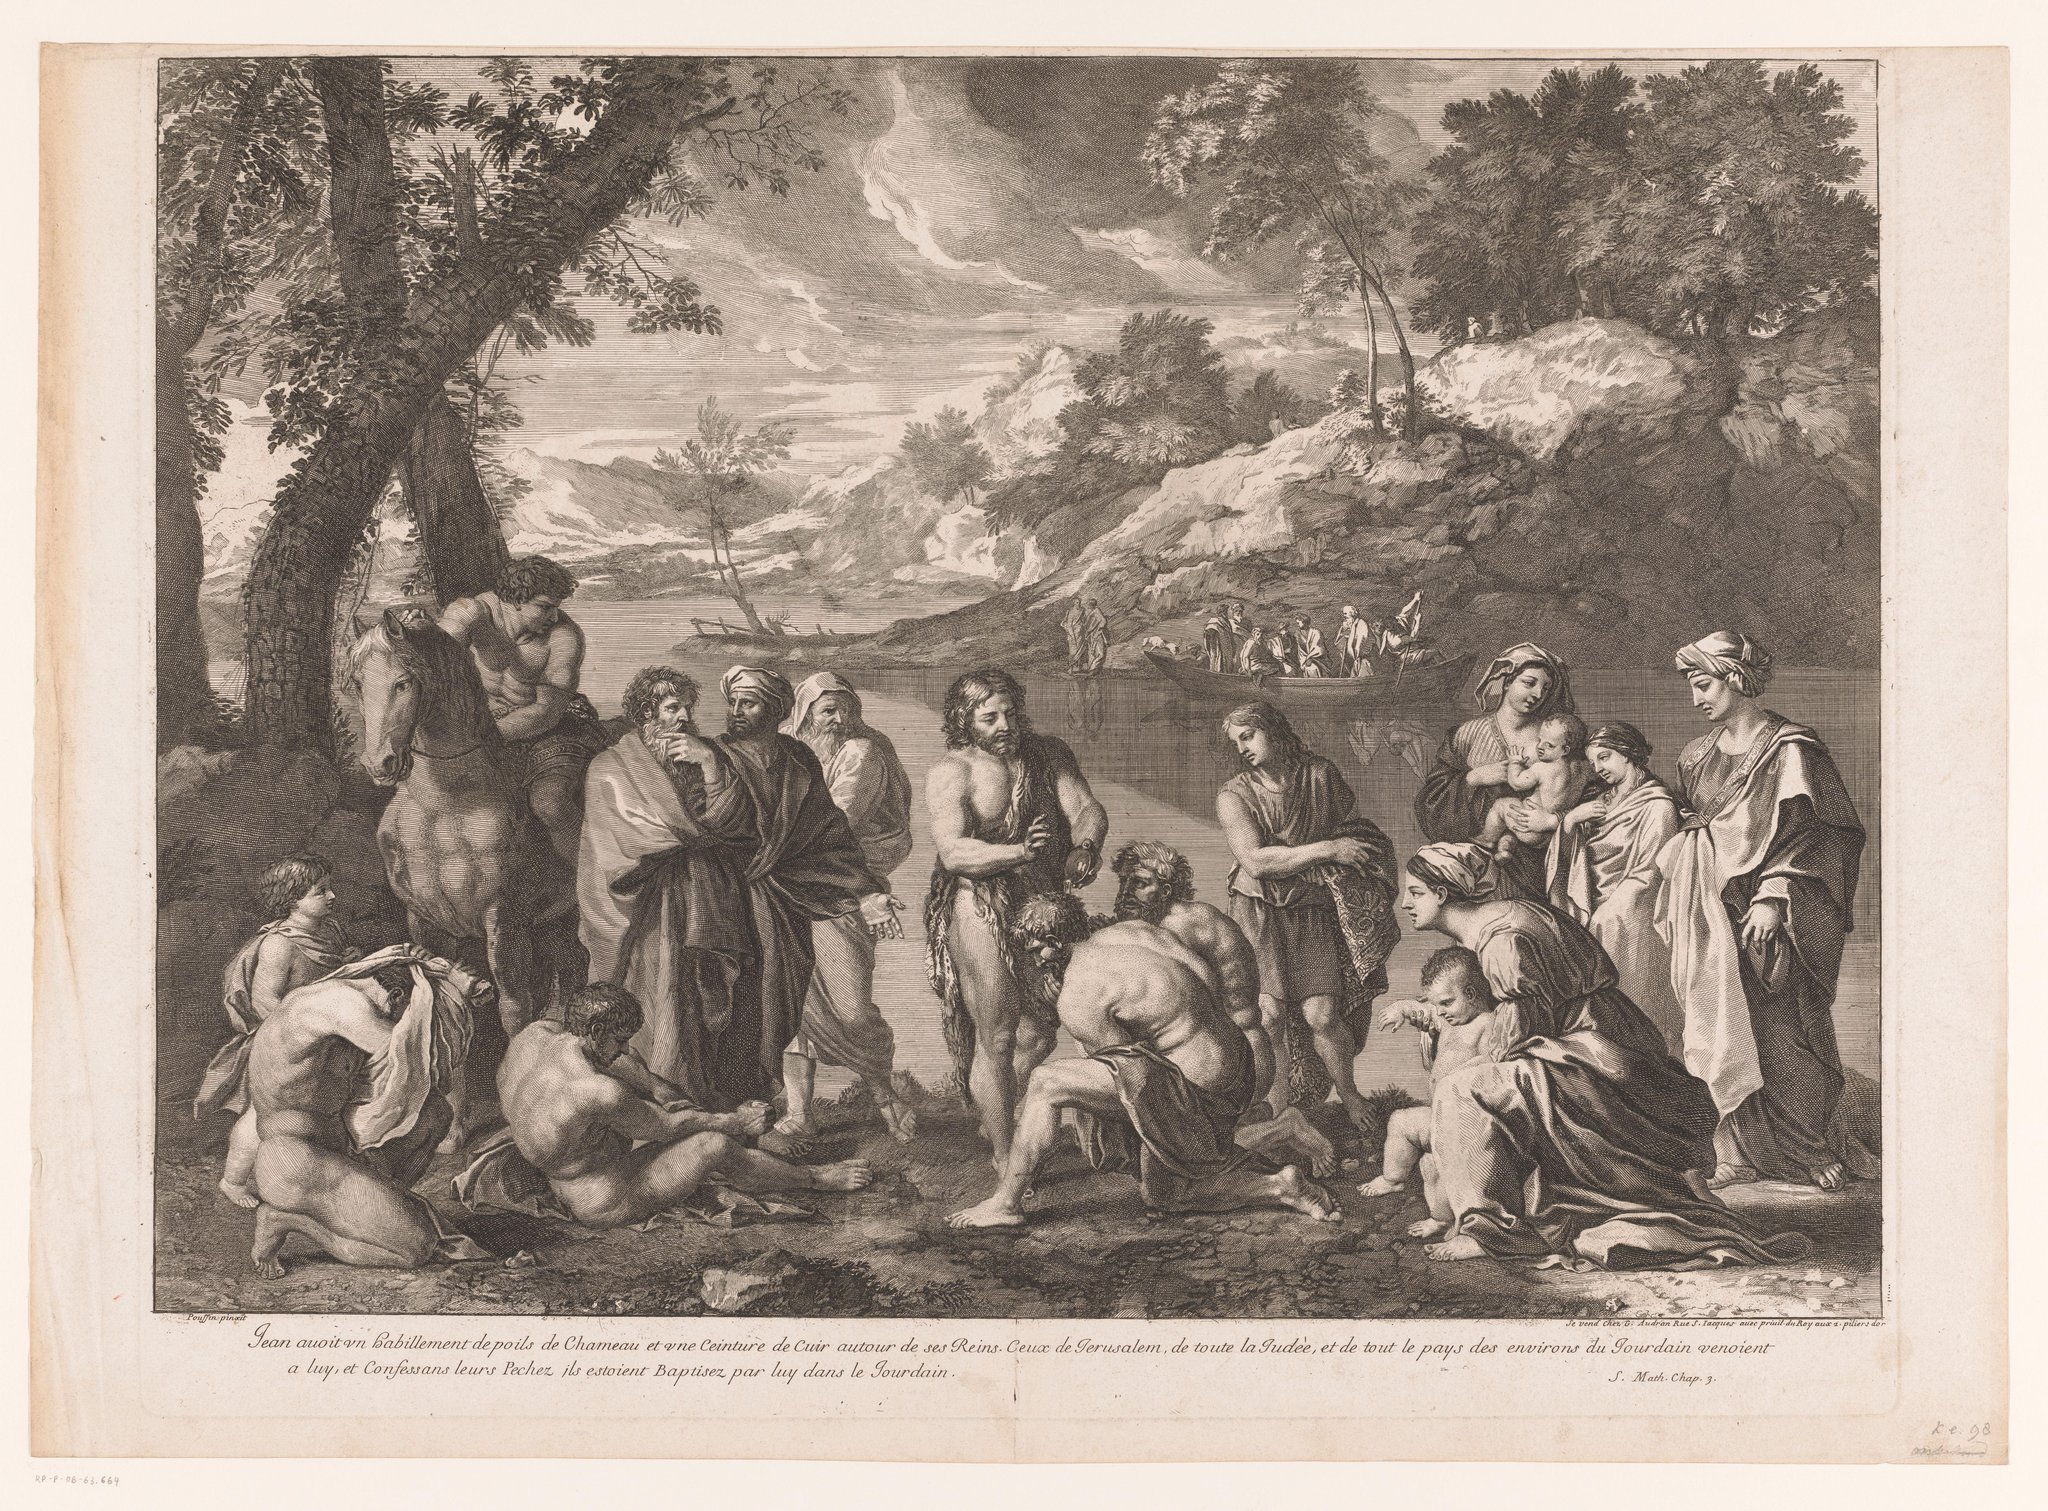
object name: print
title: Johannes de Doper bij de Jordaan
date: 1671-1703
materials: paper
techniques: engraving, etching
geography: france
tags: john the baptist baptizing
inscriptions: collector's mark: Lugt 240